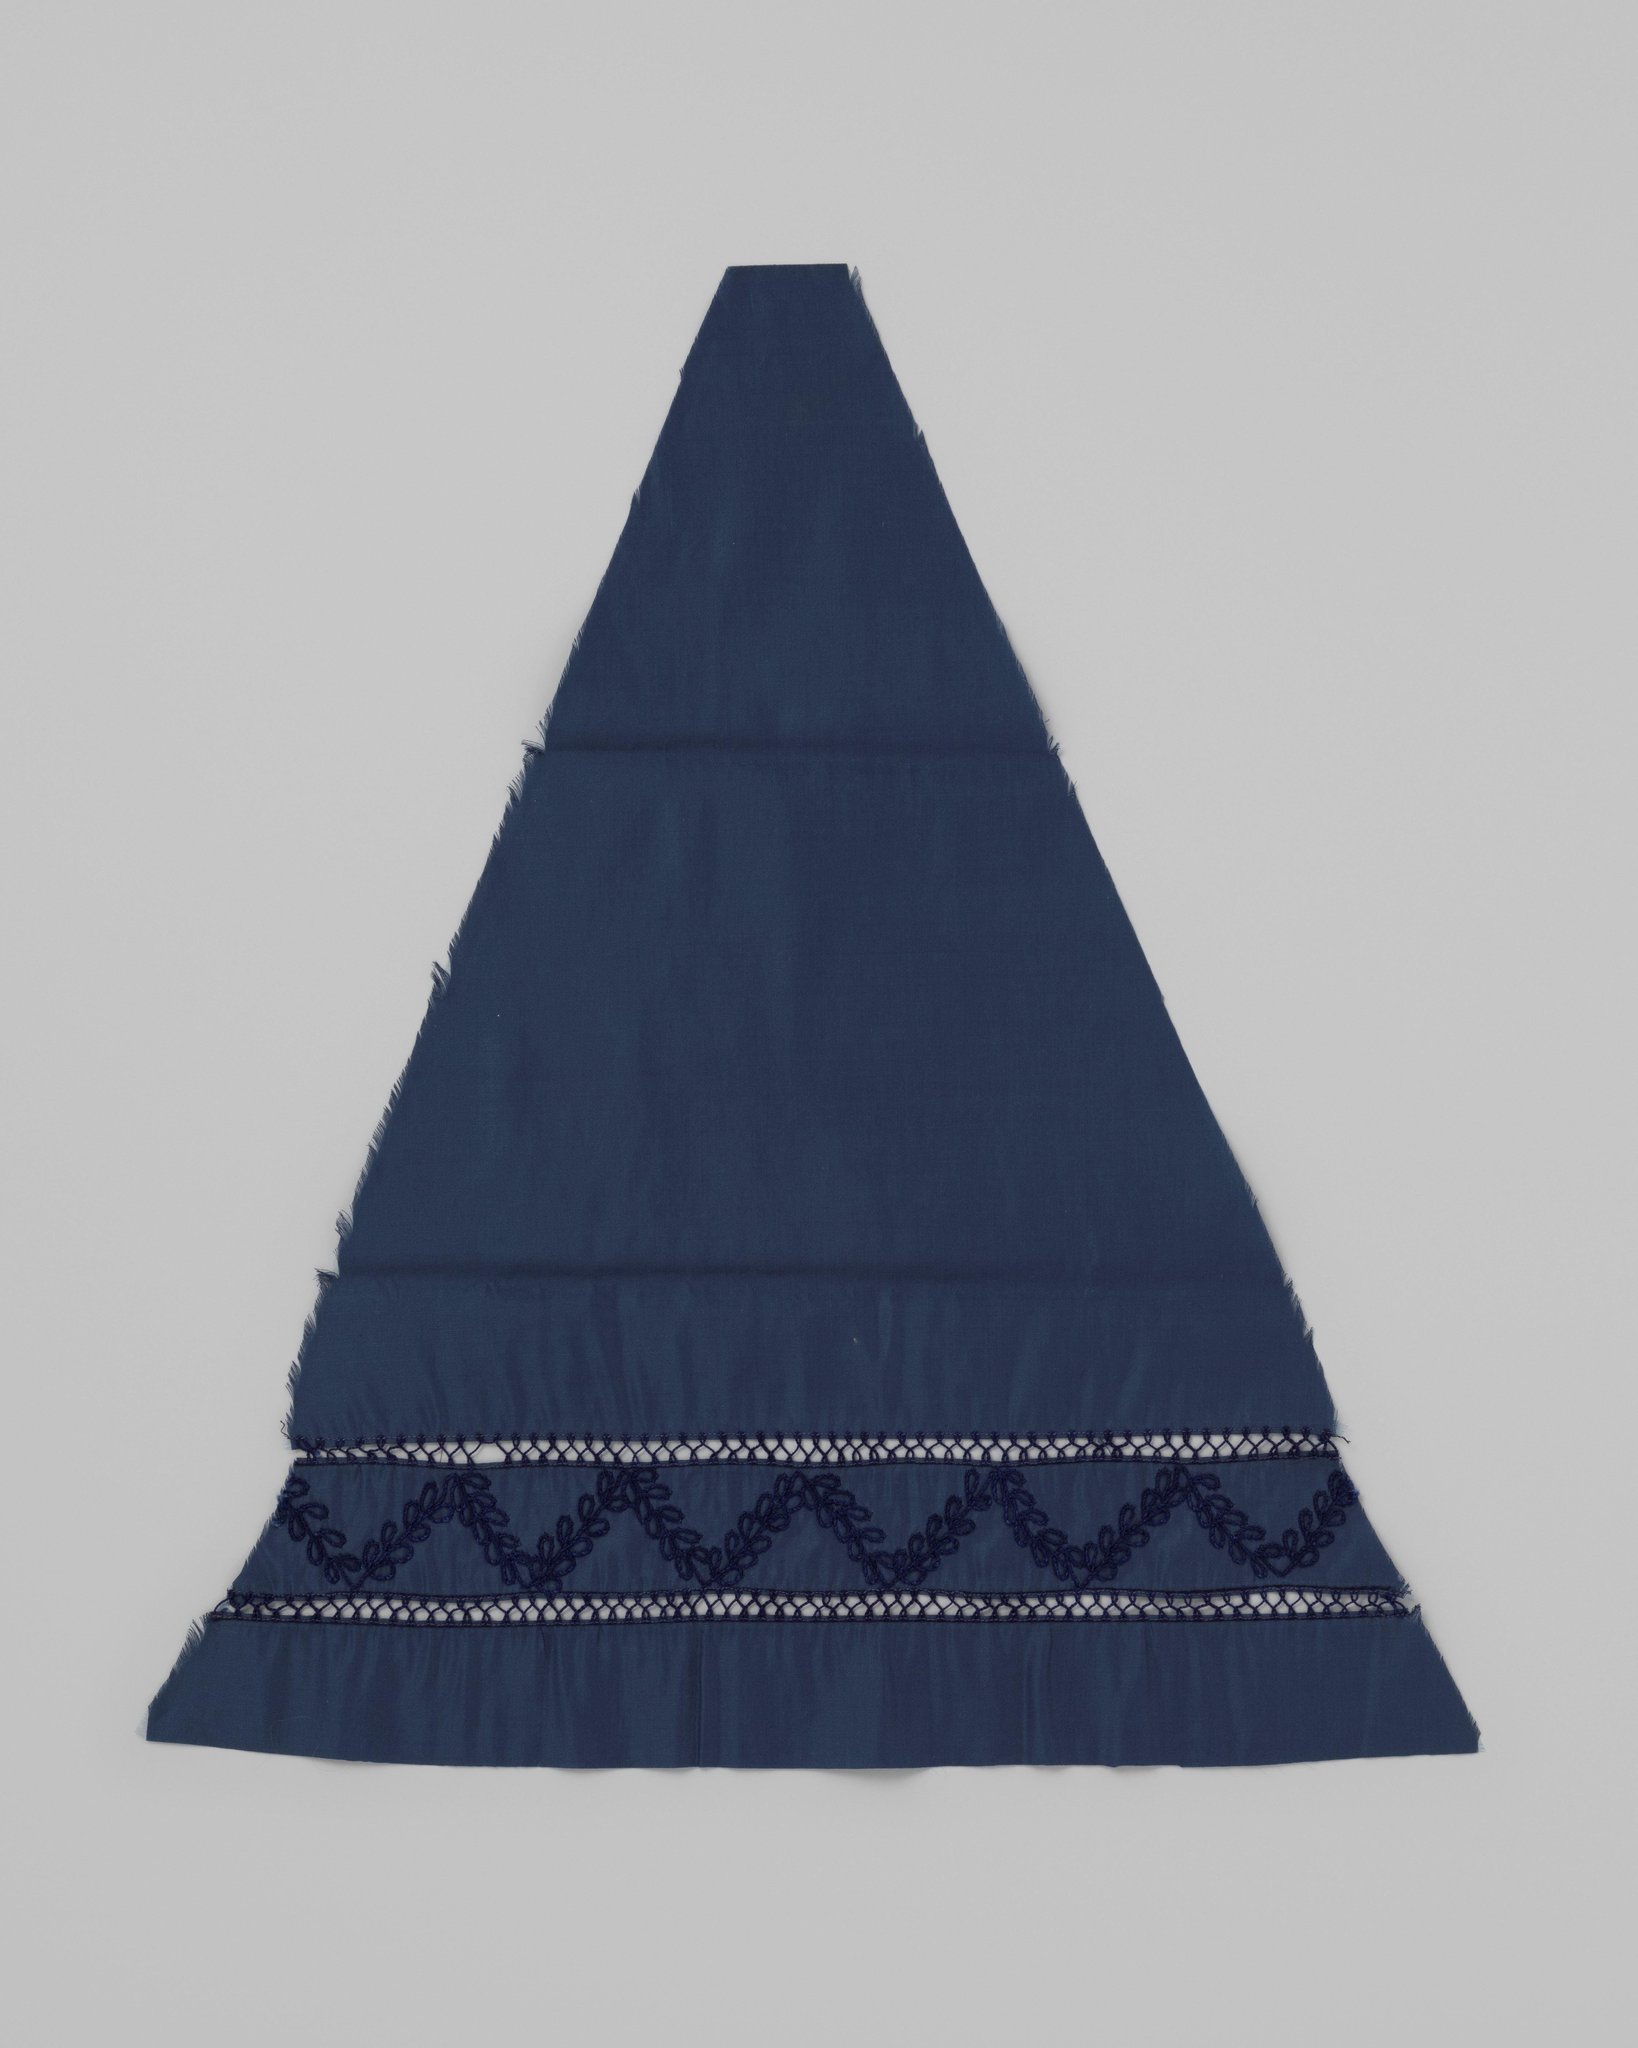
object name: parasoldek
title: Sector van een parasoldek van donkerblauwe katoen, versierd met borduurwerk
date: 1885-1900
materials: cotton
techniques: embroidered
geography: nijmegen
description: Sector van een parasoldek van donkerblauwe katoen, versierd met borduurwerk. Het borduurwerk bestaat uit twee rijen stiksteken doorgeregen met een flanelsteek, waartussen een slingerende bladrank. Aan het dek is een etiket bevestigd met een metalen klem.